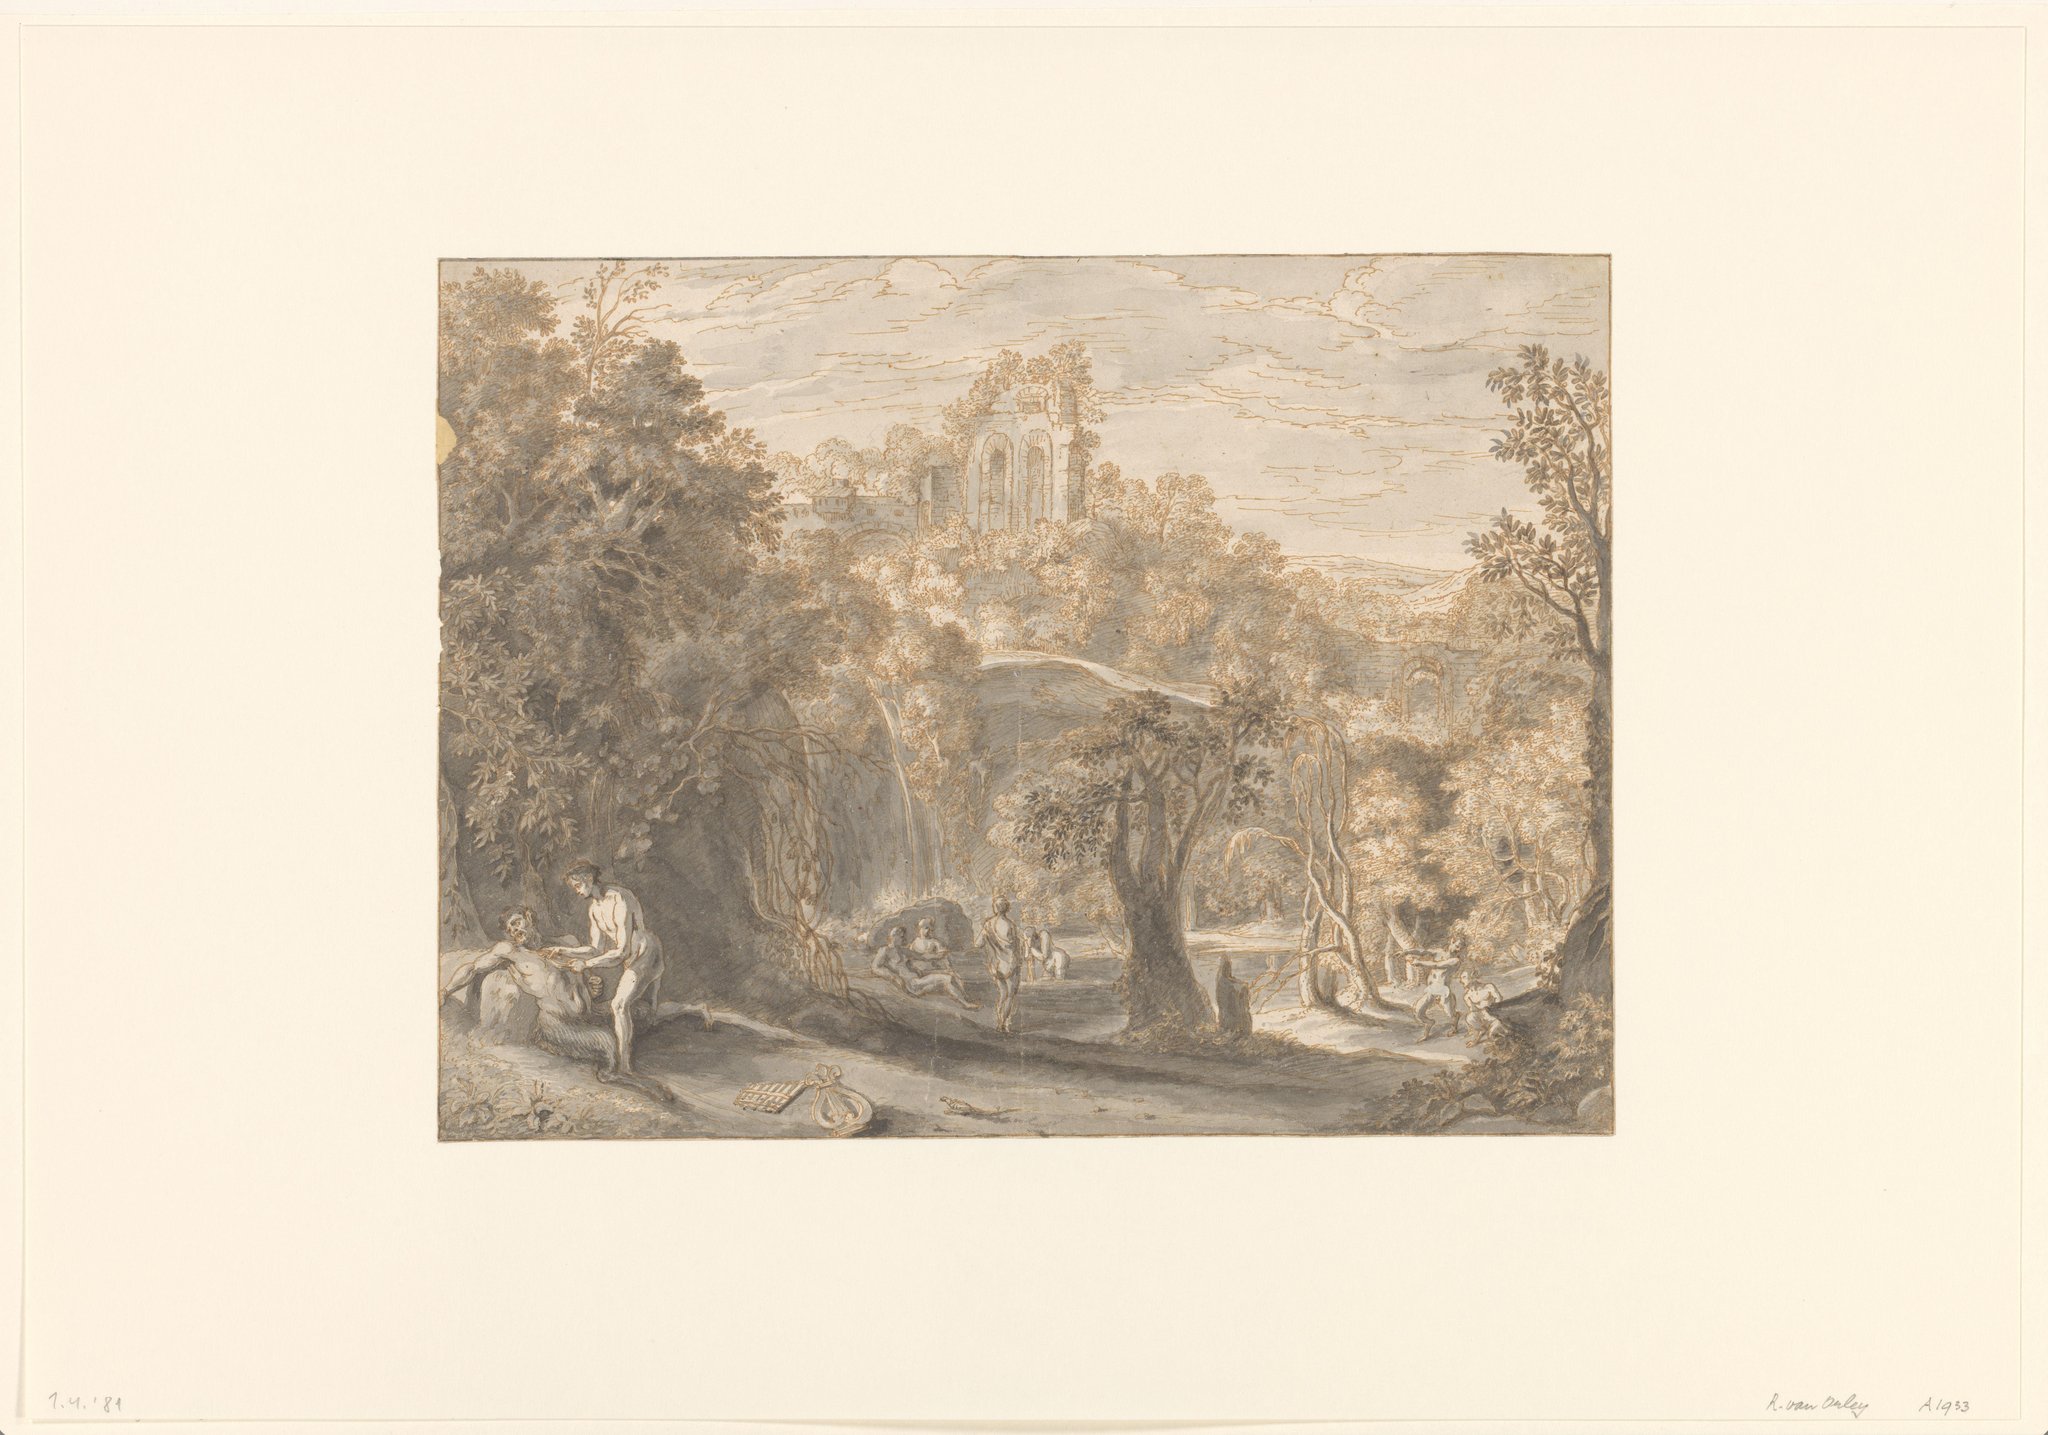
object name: drawing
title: Landschap met Apollo en Marsyas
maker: richard van orley (ii)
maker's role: draughtsman, print maker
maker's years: 1663-1732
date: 1673-1732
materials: ink, paper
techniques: brush, pen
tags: punishment of marsyas: he is flayed by apollo